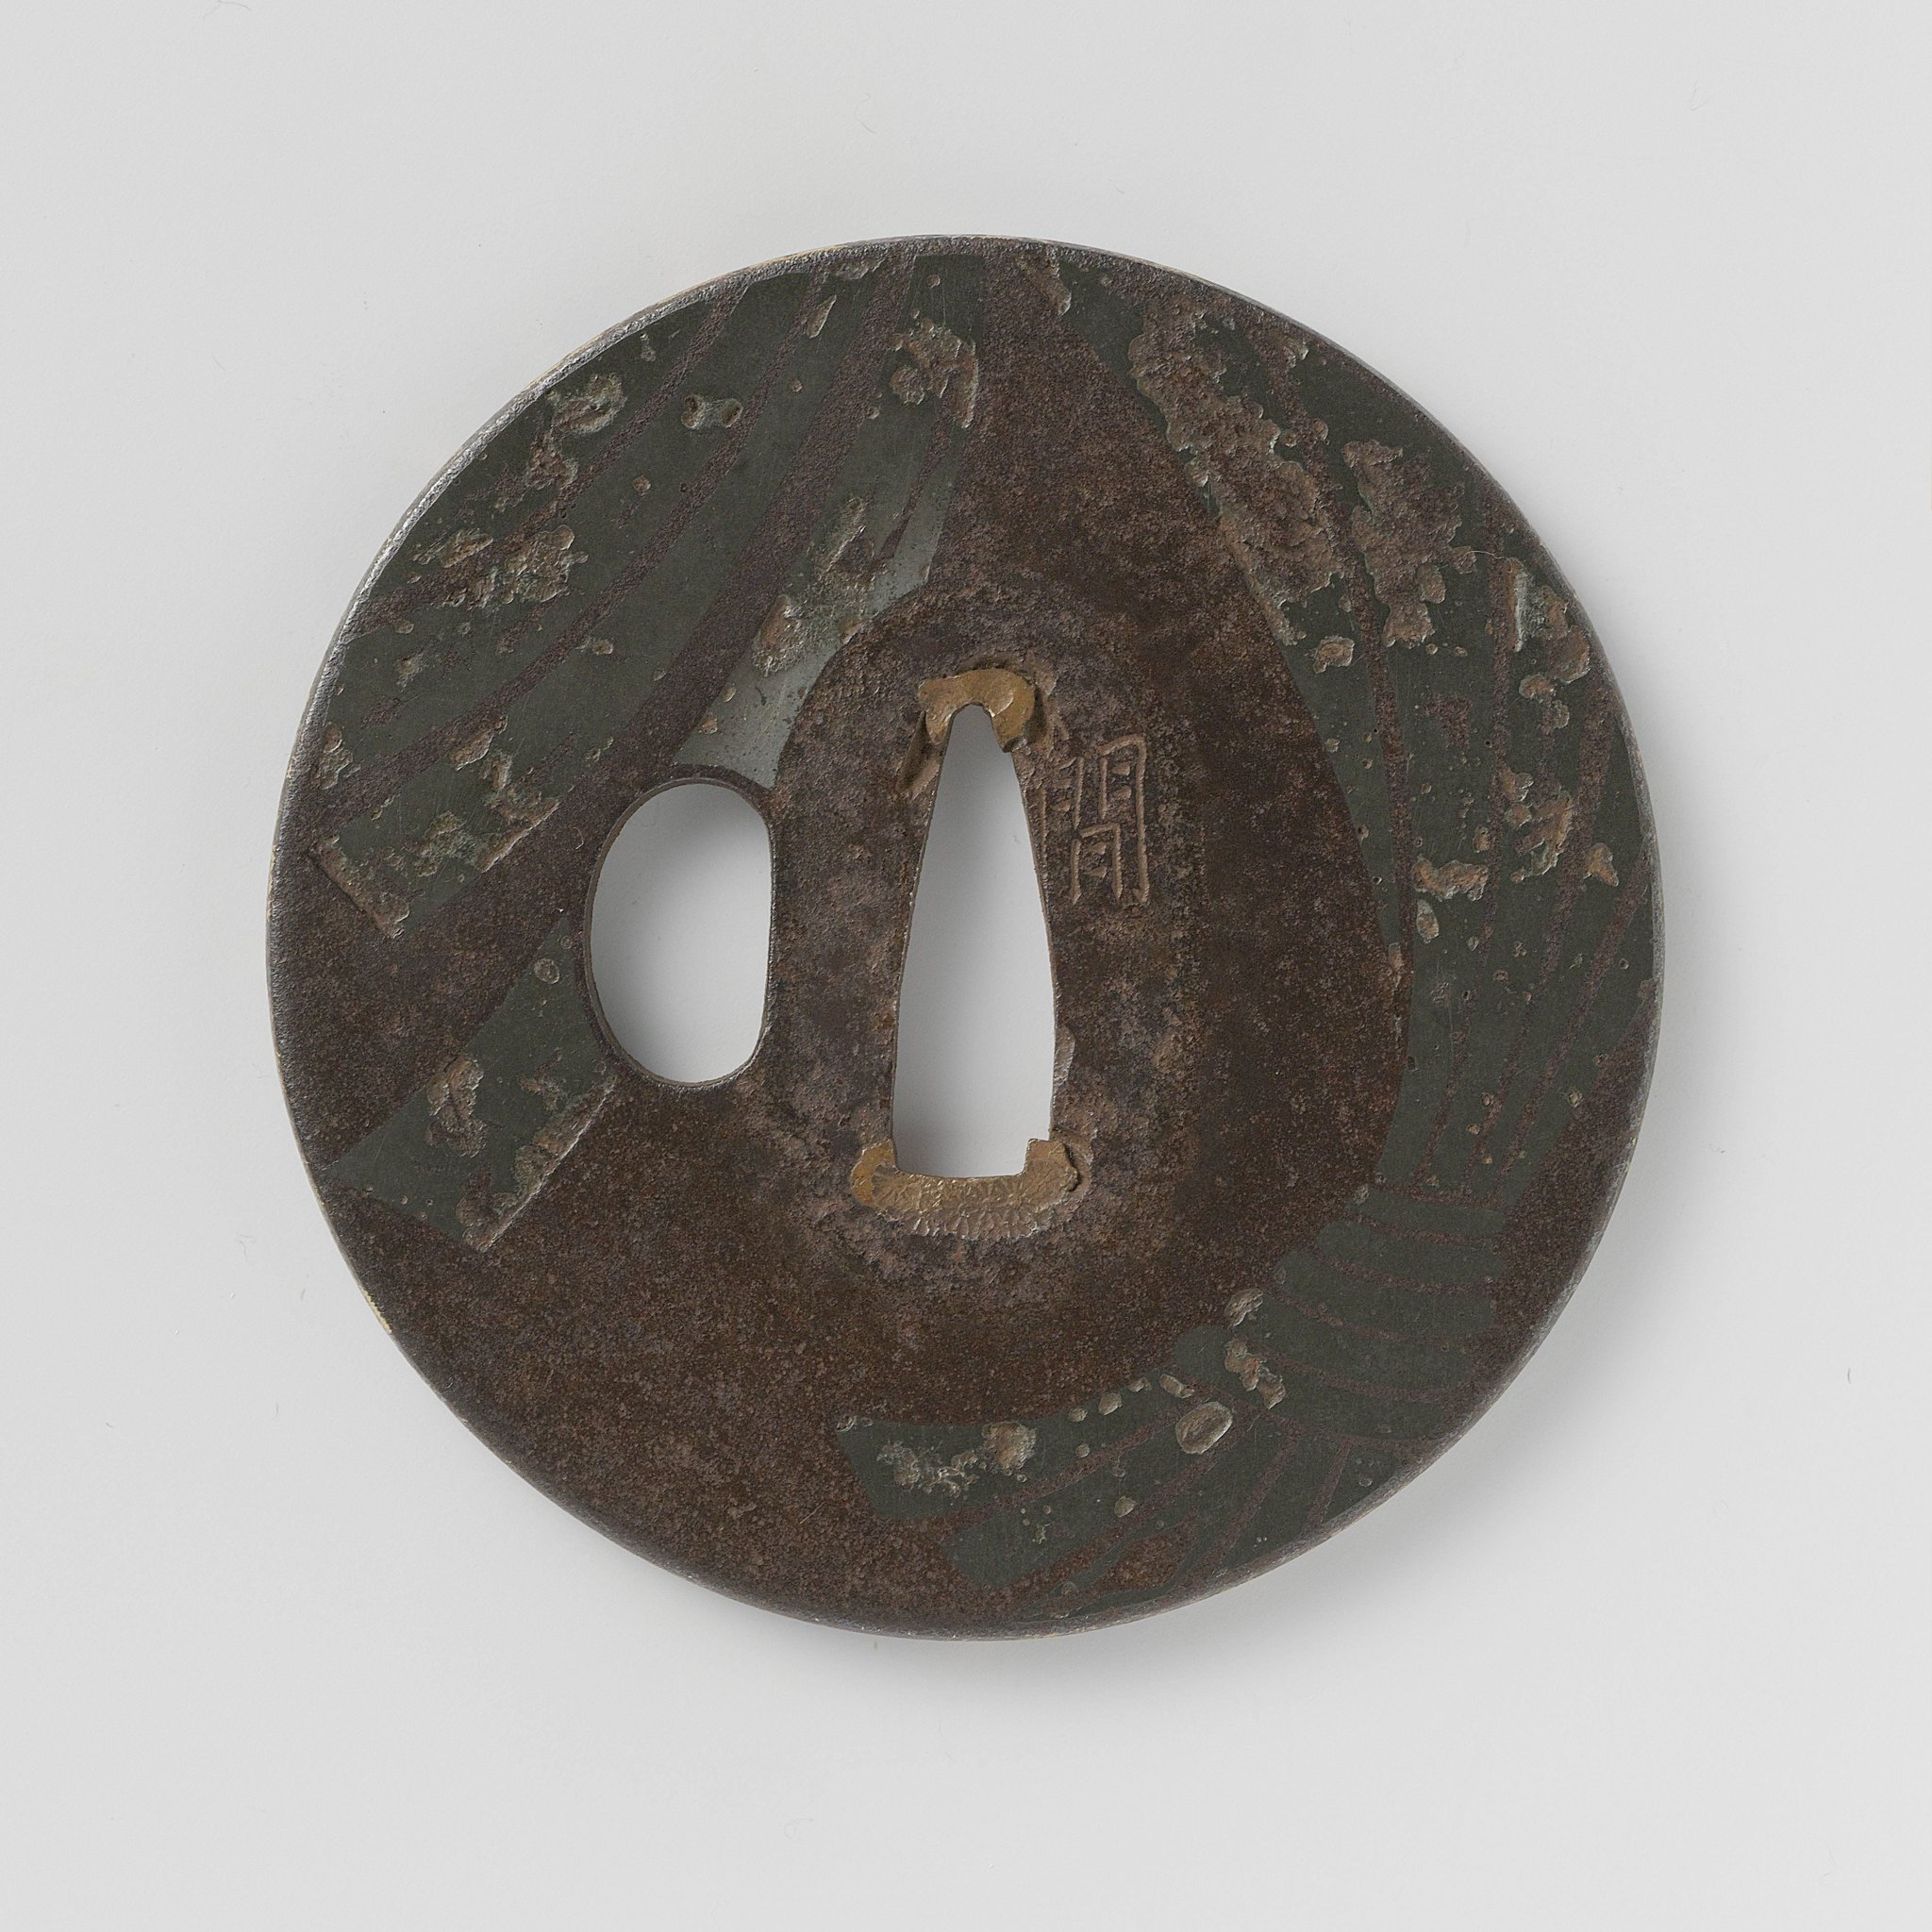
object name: tsuba, zwaardstootplaat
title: Hand guard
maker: hazama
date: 1600-1900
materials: gold, iron, silver, tin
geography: japan